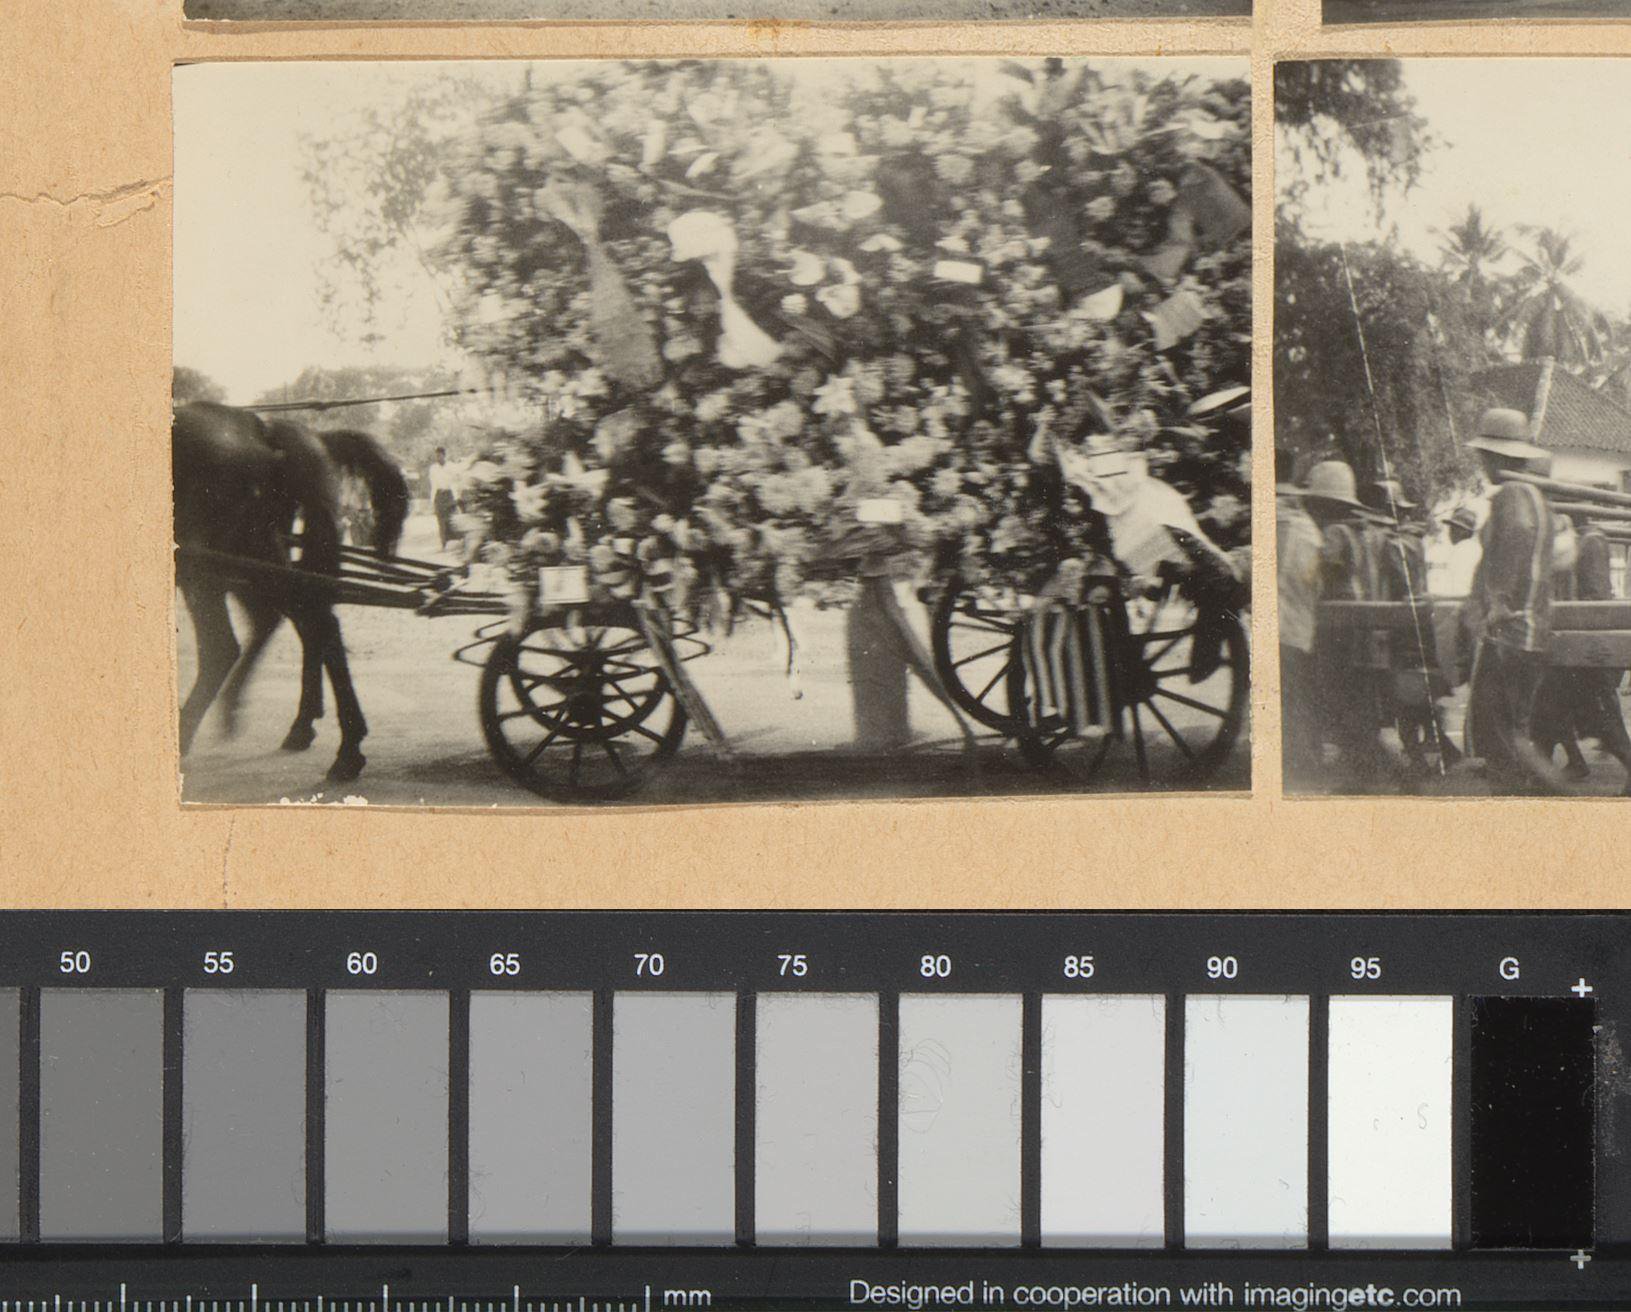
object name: photograph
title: Met bloemen versierde kar in een rouwstoet, vermoedelijk in Jogjakarta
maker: Anonymous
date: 1916-1917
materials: photographic support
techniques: gelatin silver print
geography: jogjakarta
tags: flowers, four-wheeled, animal-drawn vehicle, e.g.: cab, carriage, coach, cortege, funeral procession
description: Onderdeel van Familiealbum met foto's van een familie in de voormalige kolonie Nederlands-Indië en van een suikerfabriek in Purworejo.